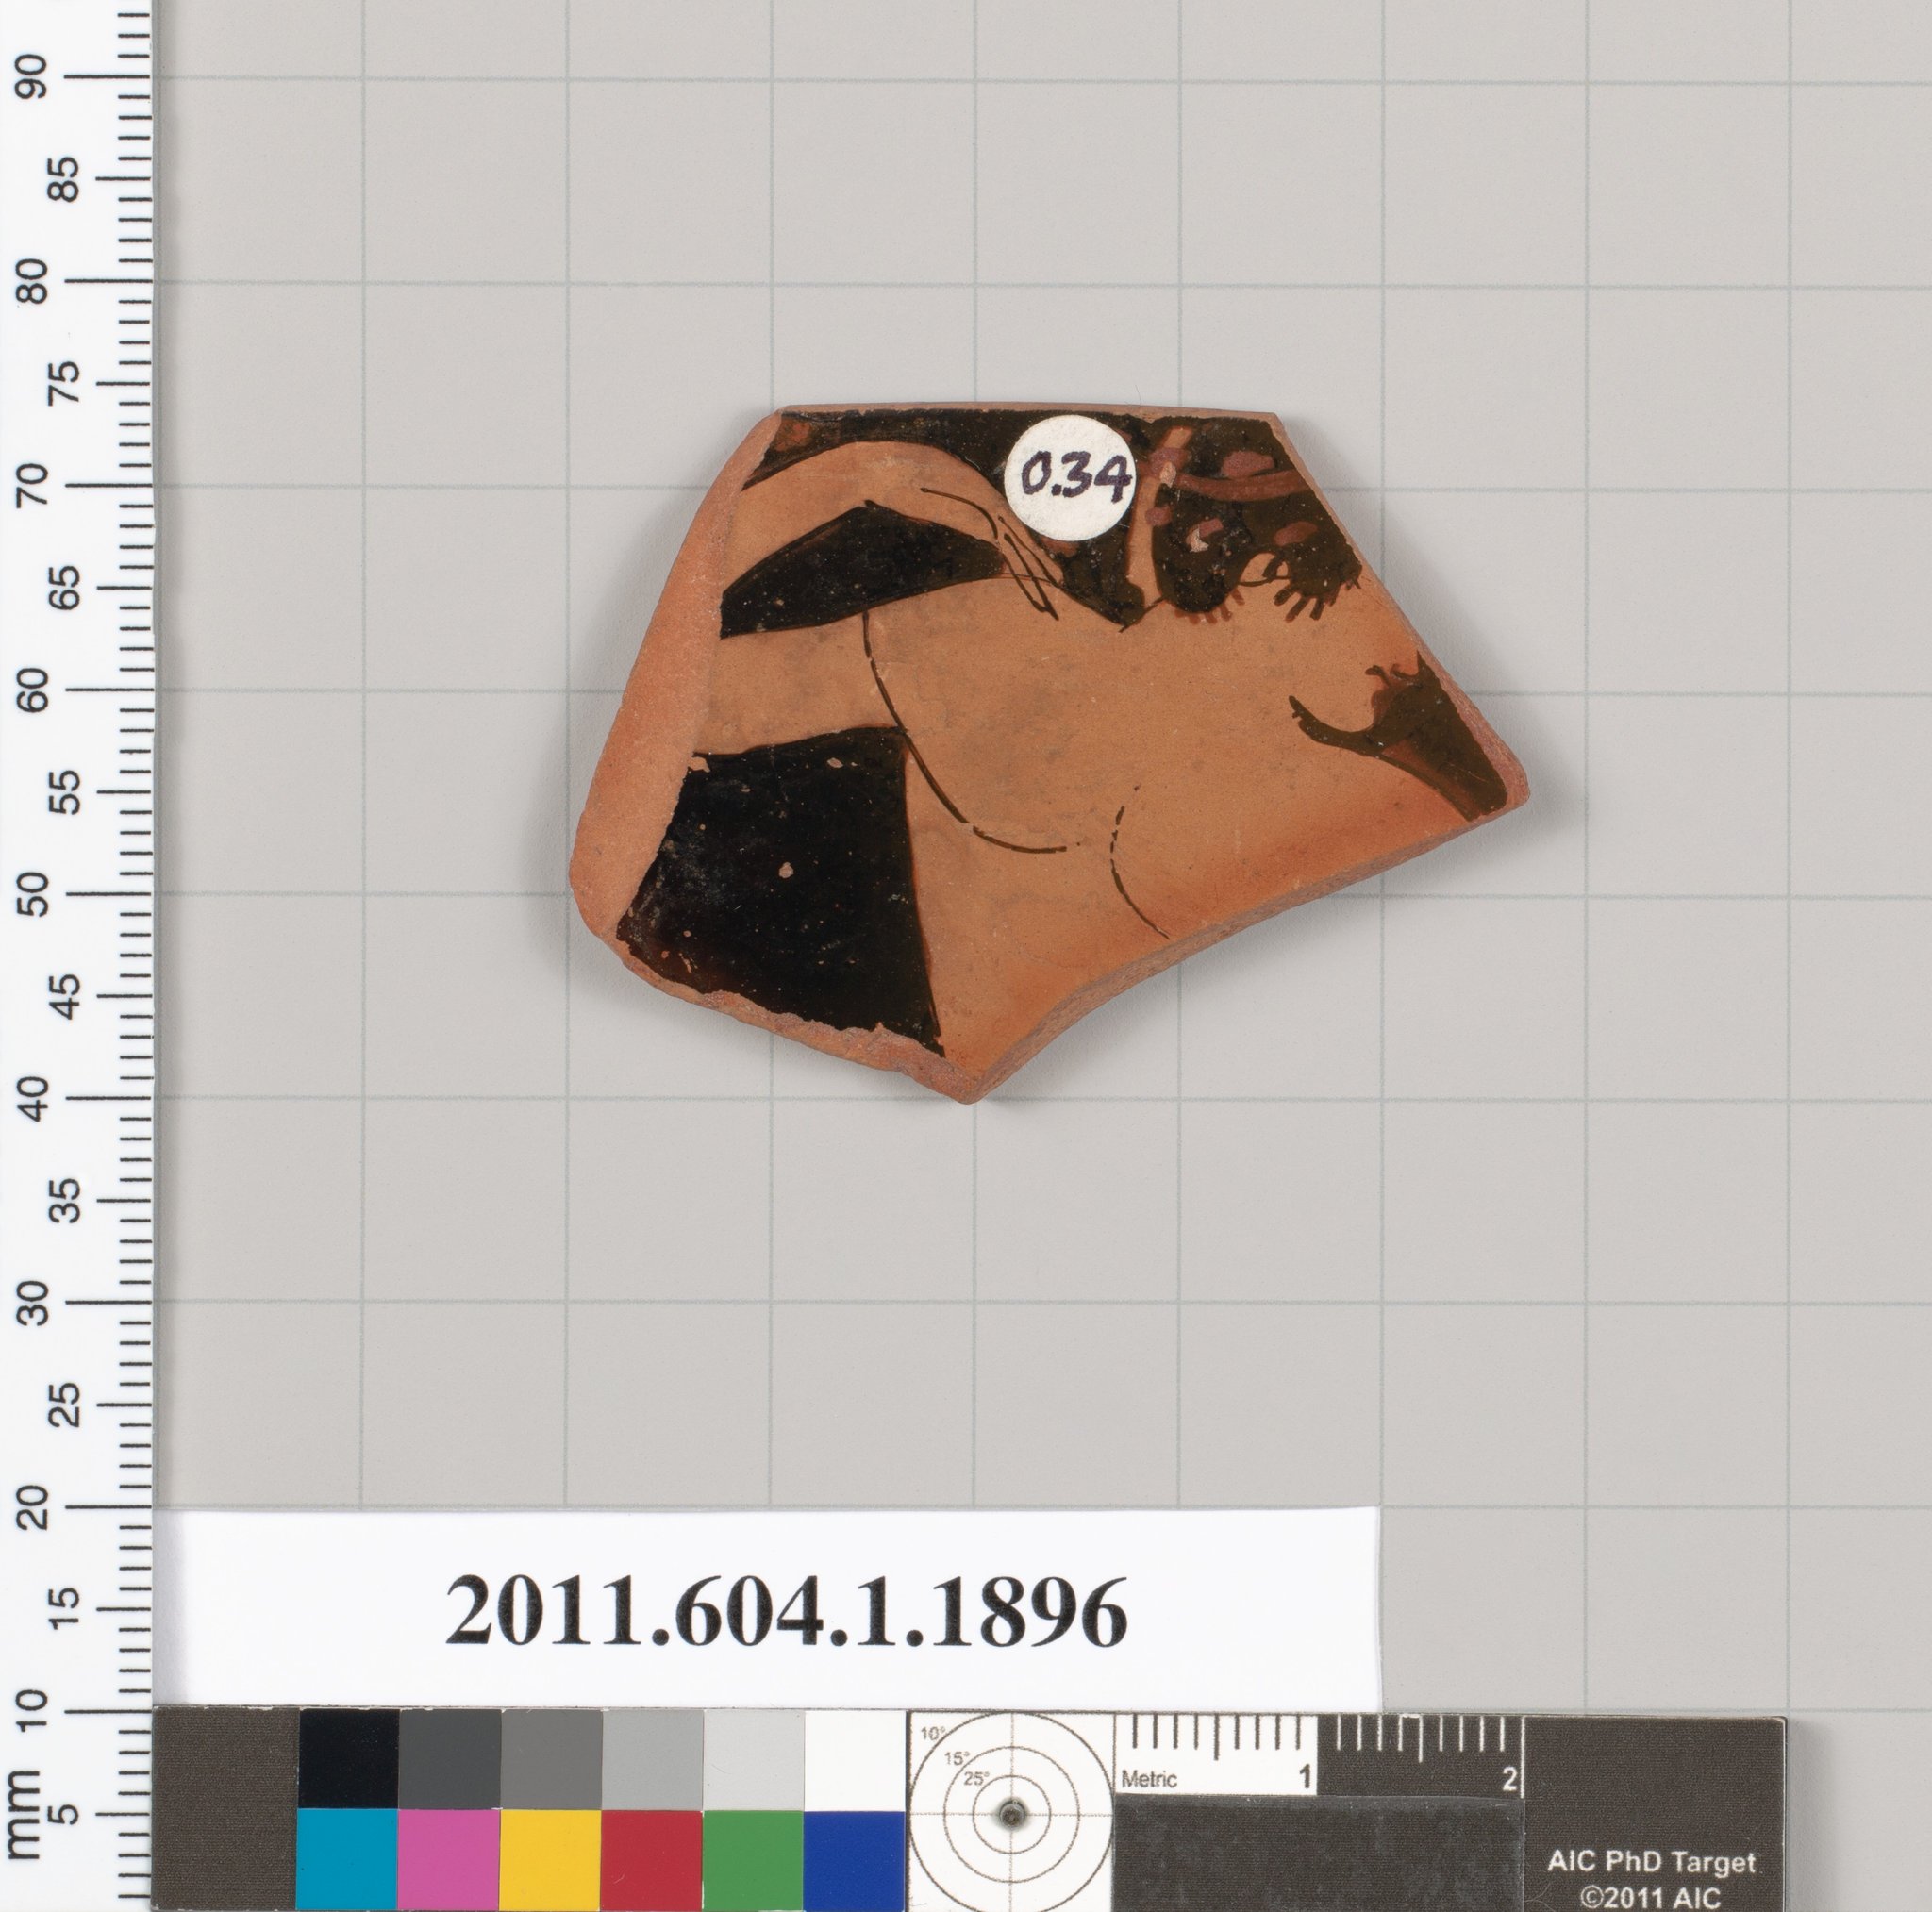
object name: kylix fragment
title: Terracotta rim fragment of a kylix (drinking cup)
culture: greek, attic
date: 520-510 BCE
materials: terracotta